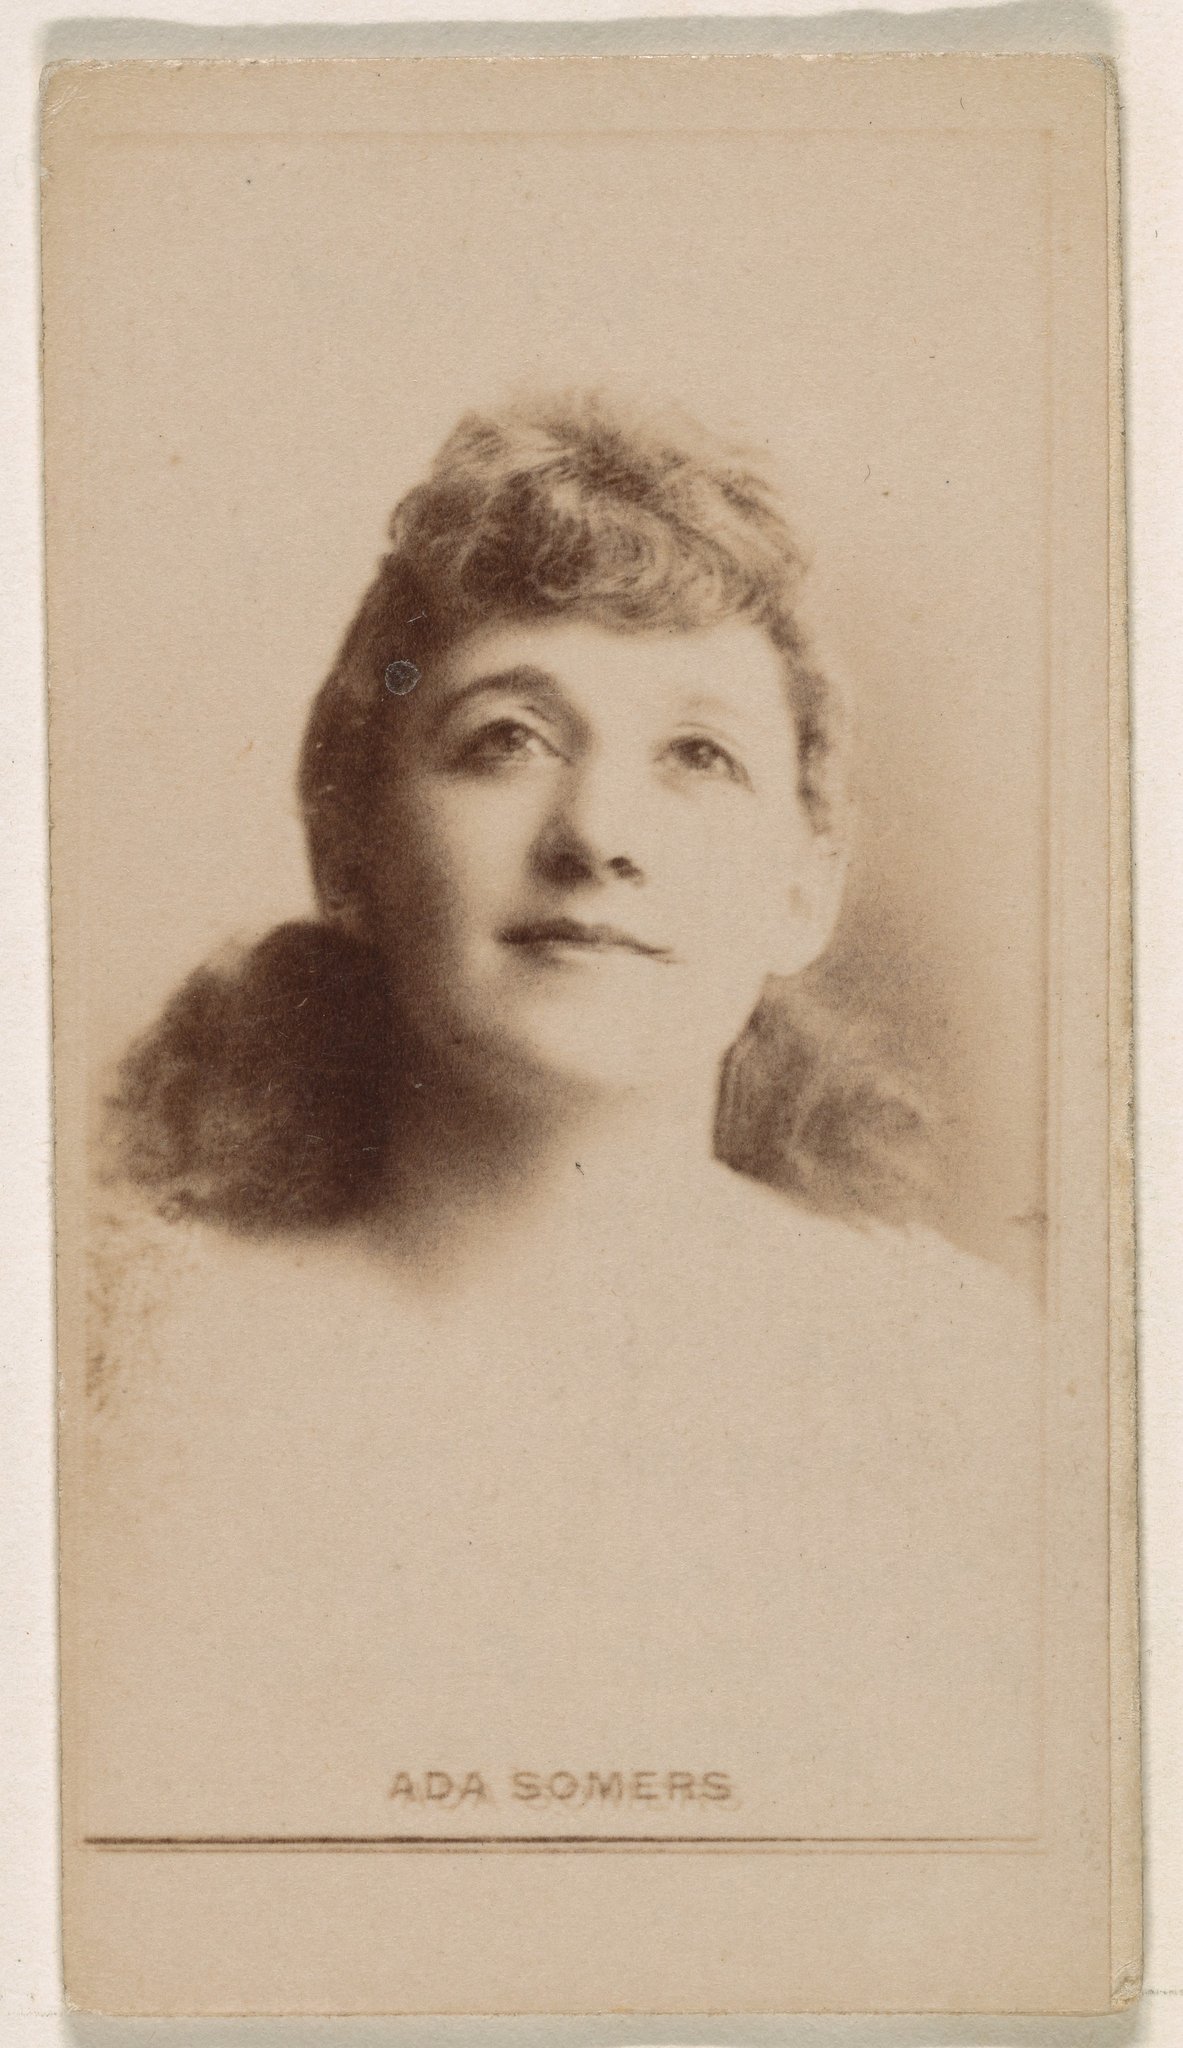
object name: photograph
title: Ada Somers, from the Actresses series (N245) issued by Kinney Brothers to promote Sweet Caporal Cigarettes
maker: kinney brothers tobacco company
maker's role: publisher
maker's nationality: american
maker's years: 1869-2011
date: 1890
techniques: albumen silver print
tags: portraits,women,actresses